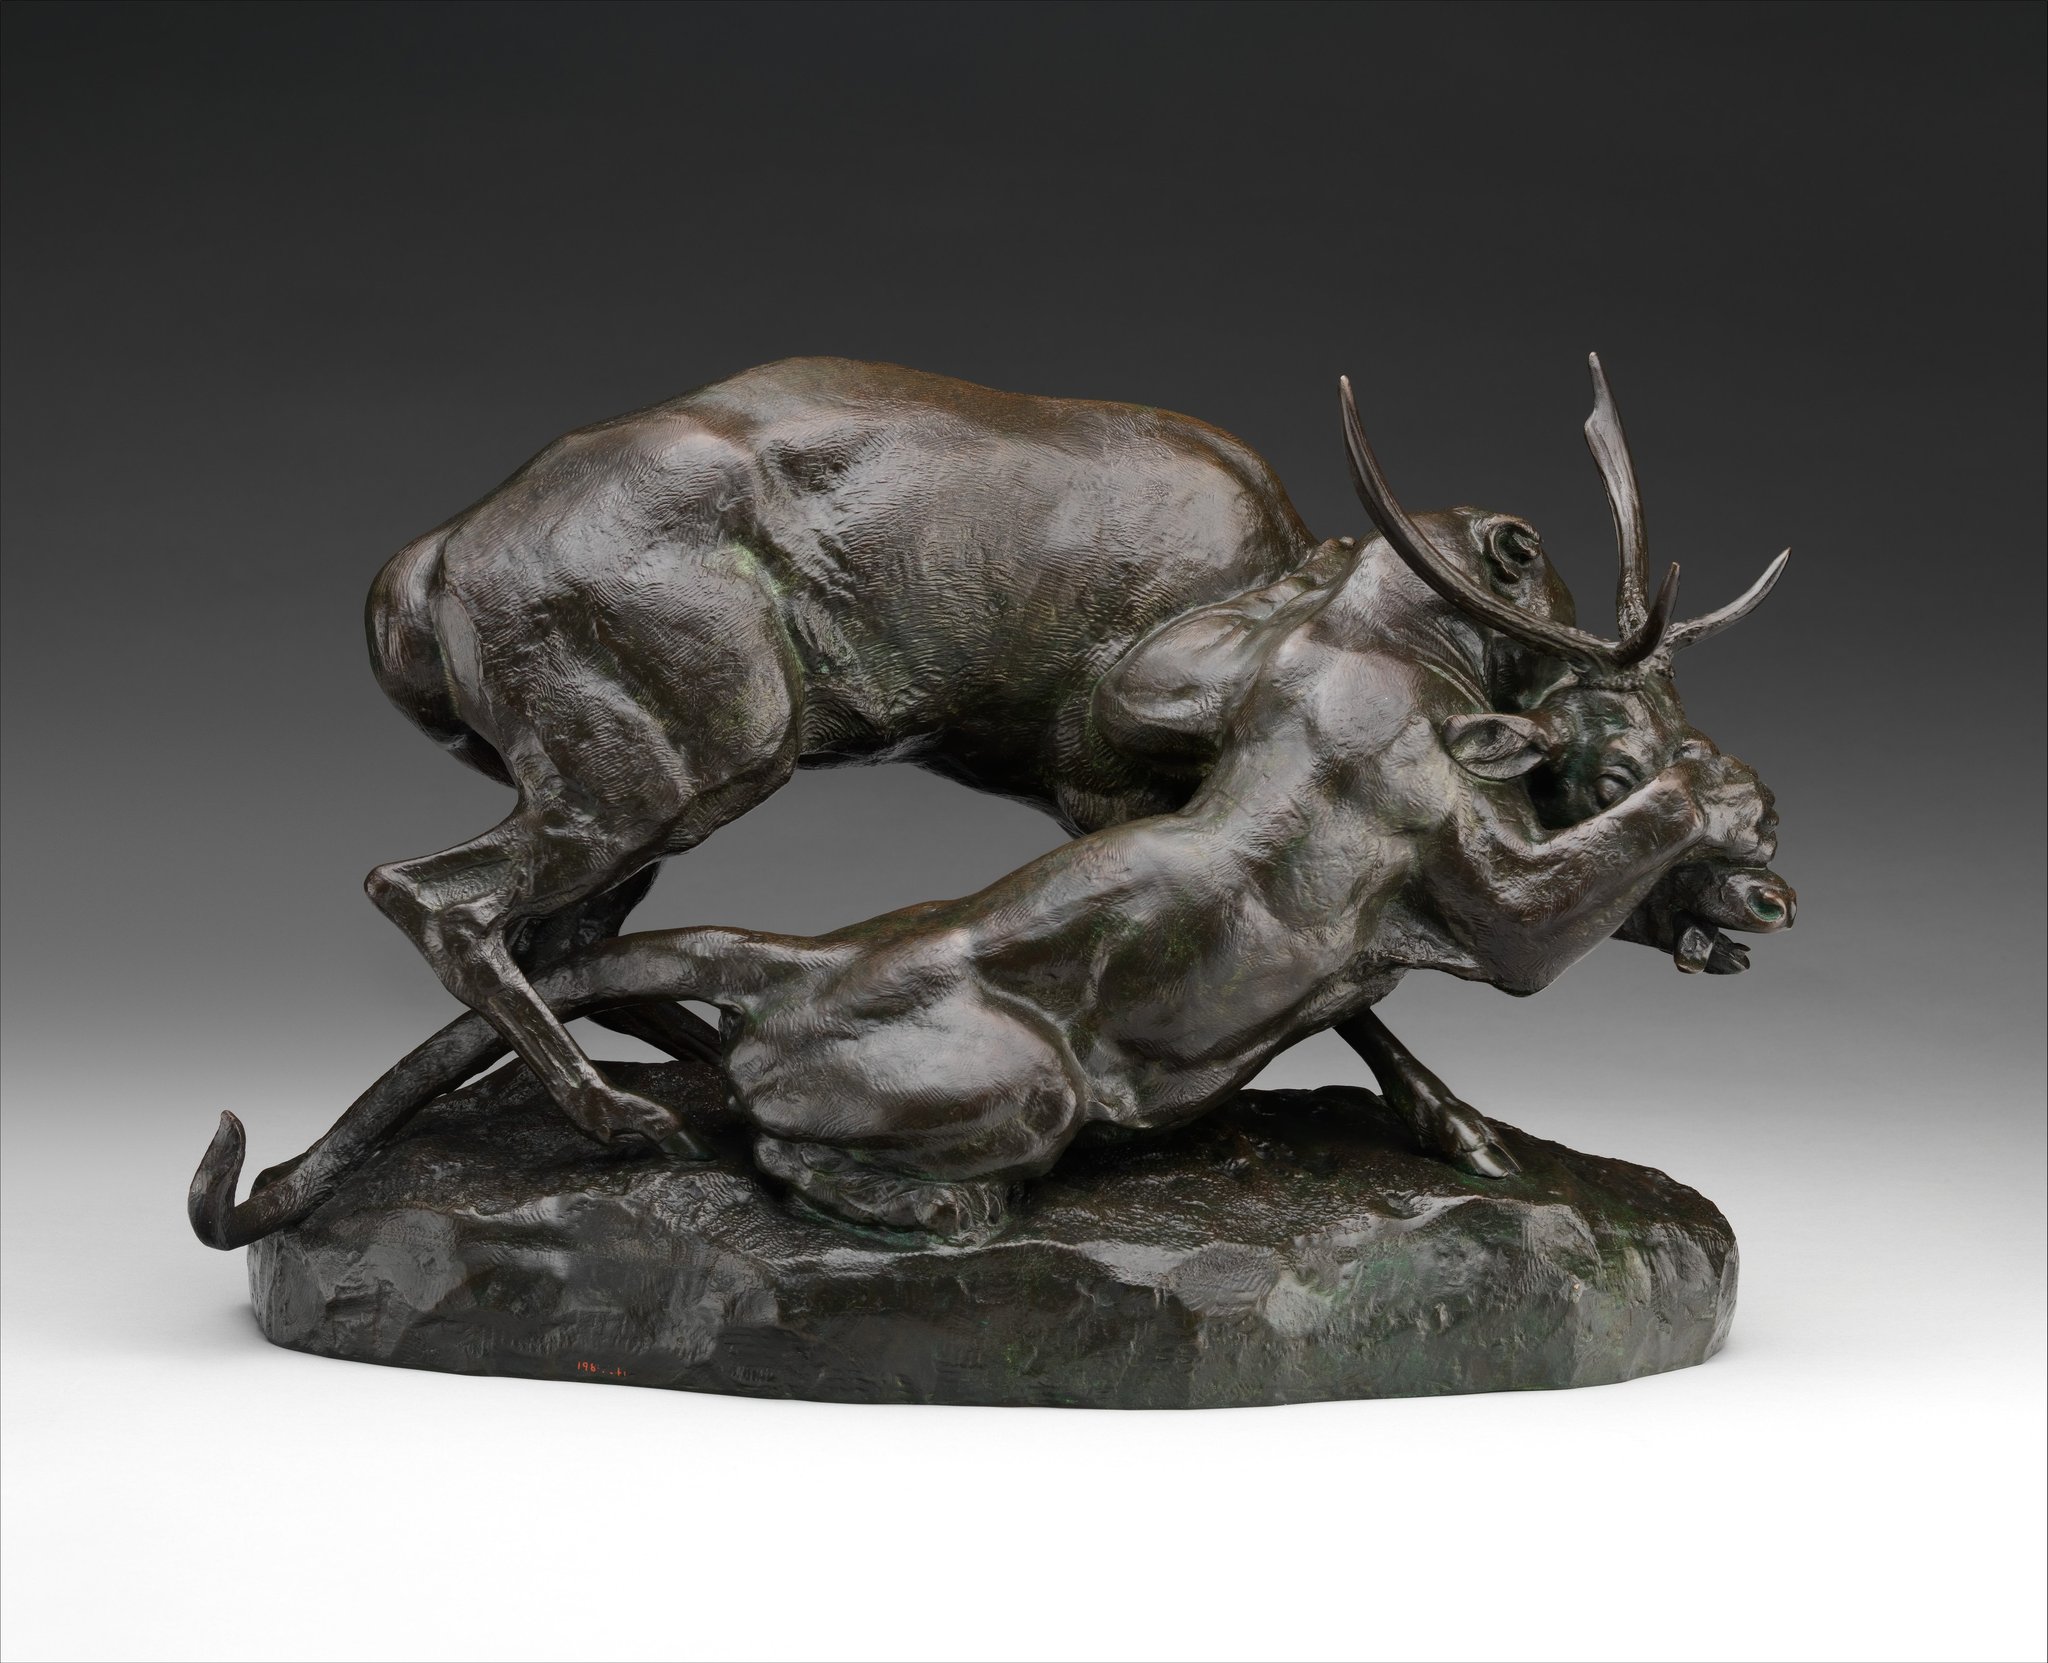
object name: statuette group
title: Panther Seizing a Stag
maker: antoine-louis barye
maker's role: artist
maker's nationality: french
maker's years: 1795-1875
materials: bronze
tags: animals,deer